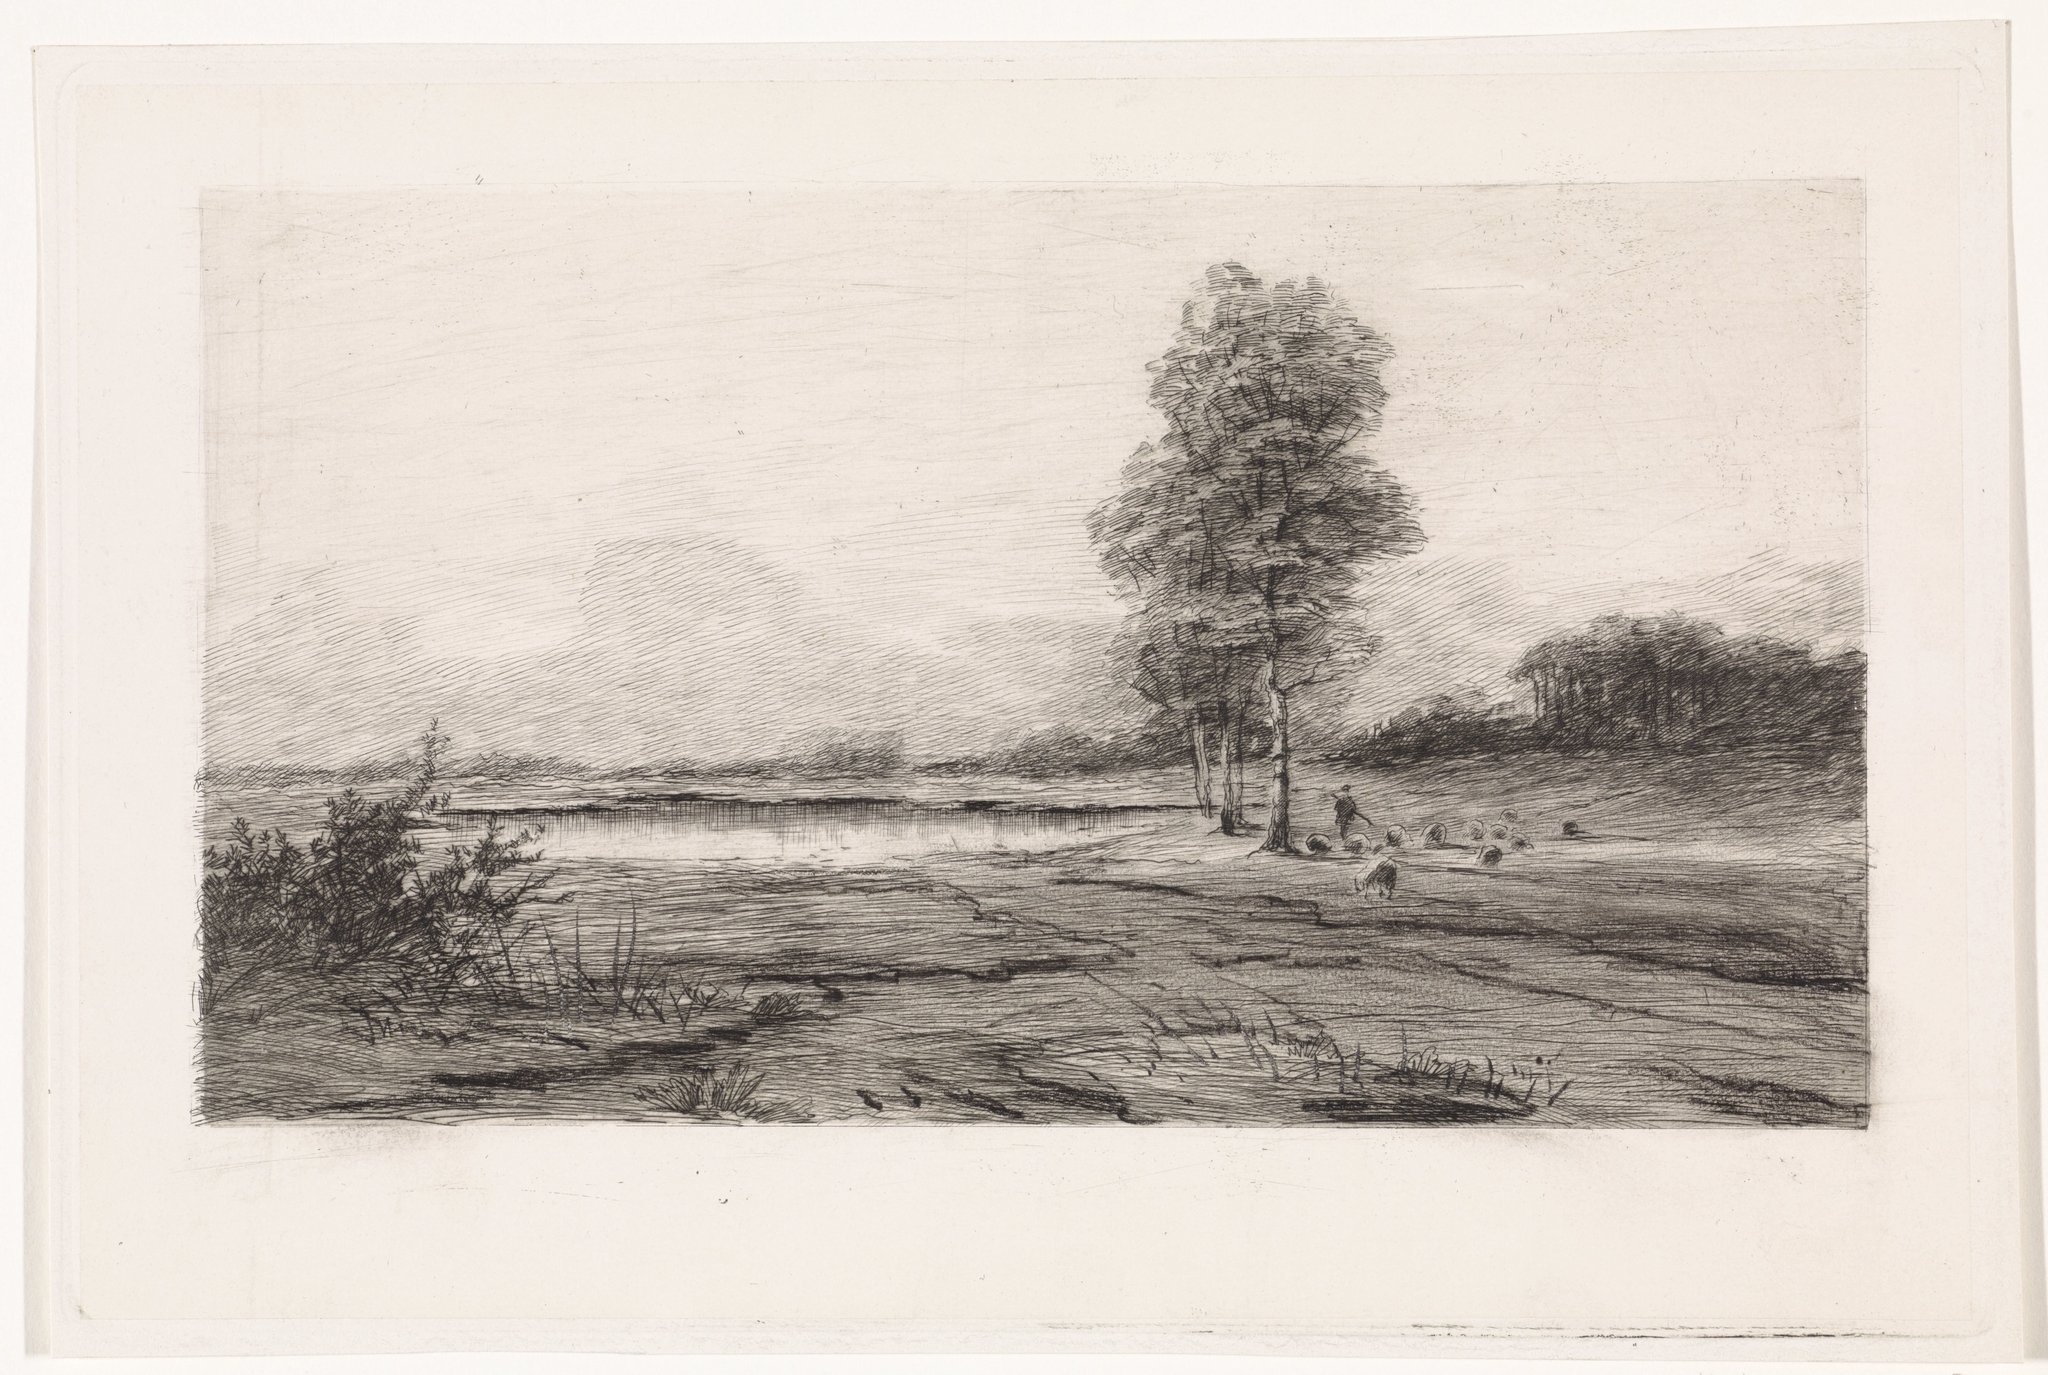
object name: print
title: Landschap met waterplas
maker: elias stark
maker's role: draughtsman, print maker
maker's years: 1849-1933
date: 1801-1891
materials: chalk, paper, pencil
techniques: etching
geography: nieuwer-amstel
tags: herding, herdsman, herdswoman, shepherd, shepherdess, cowherd, etc., pond, pool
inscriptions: collector's mark: Lugt 2228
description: Landschap met een waterplas. Bij enkele bomen staat een herder met zijn schapen.